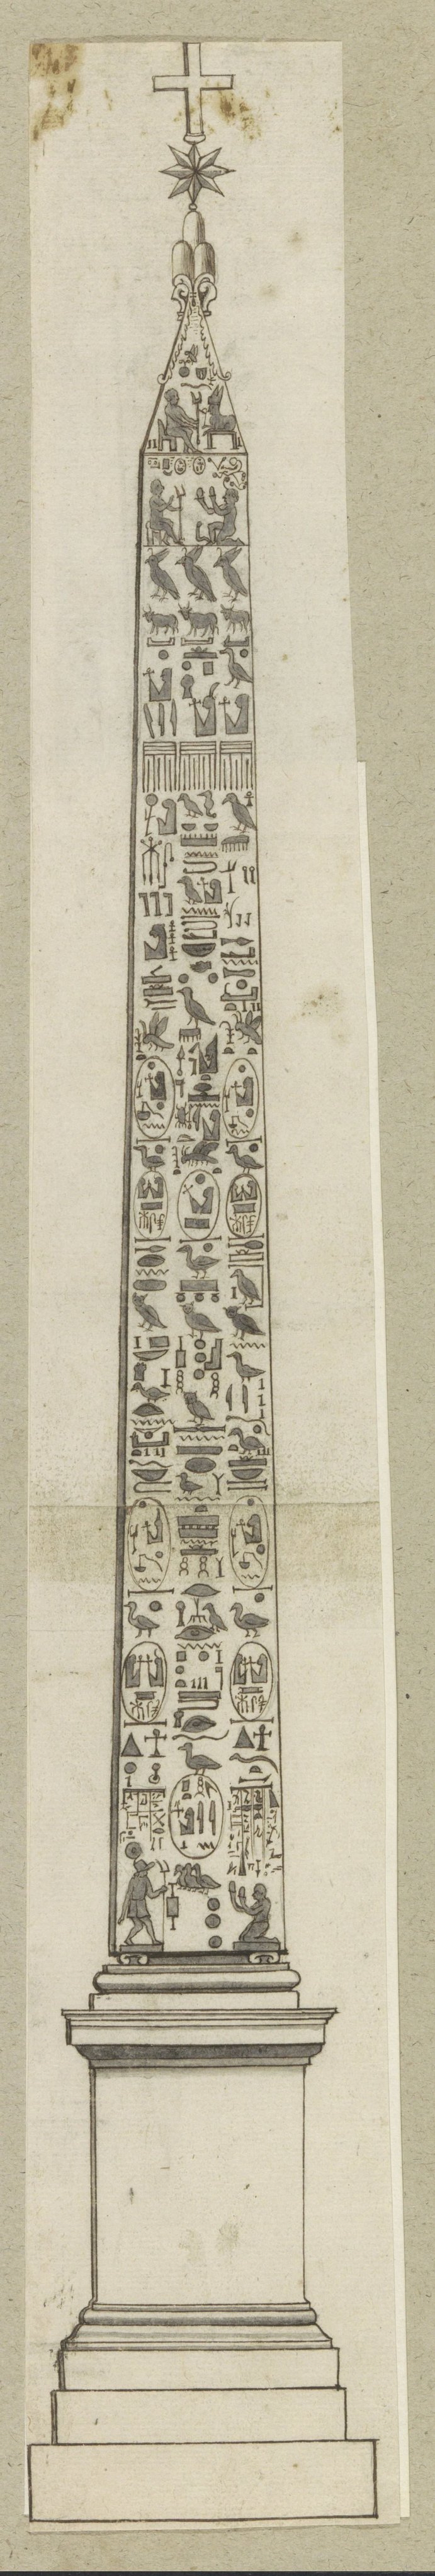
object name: album leaf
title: Egyptische obelisk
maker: Anonymous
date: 1550-1650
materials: ink, paper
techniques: brush, pen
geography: italy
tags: obelisk, needle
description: De tekening maakt deel uit van een album.